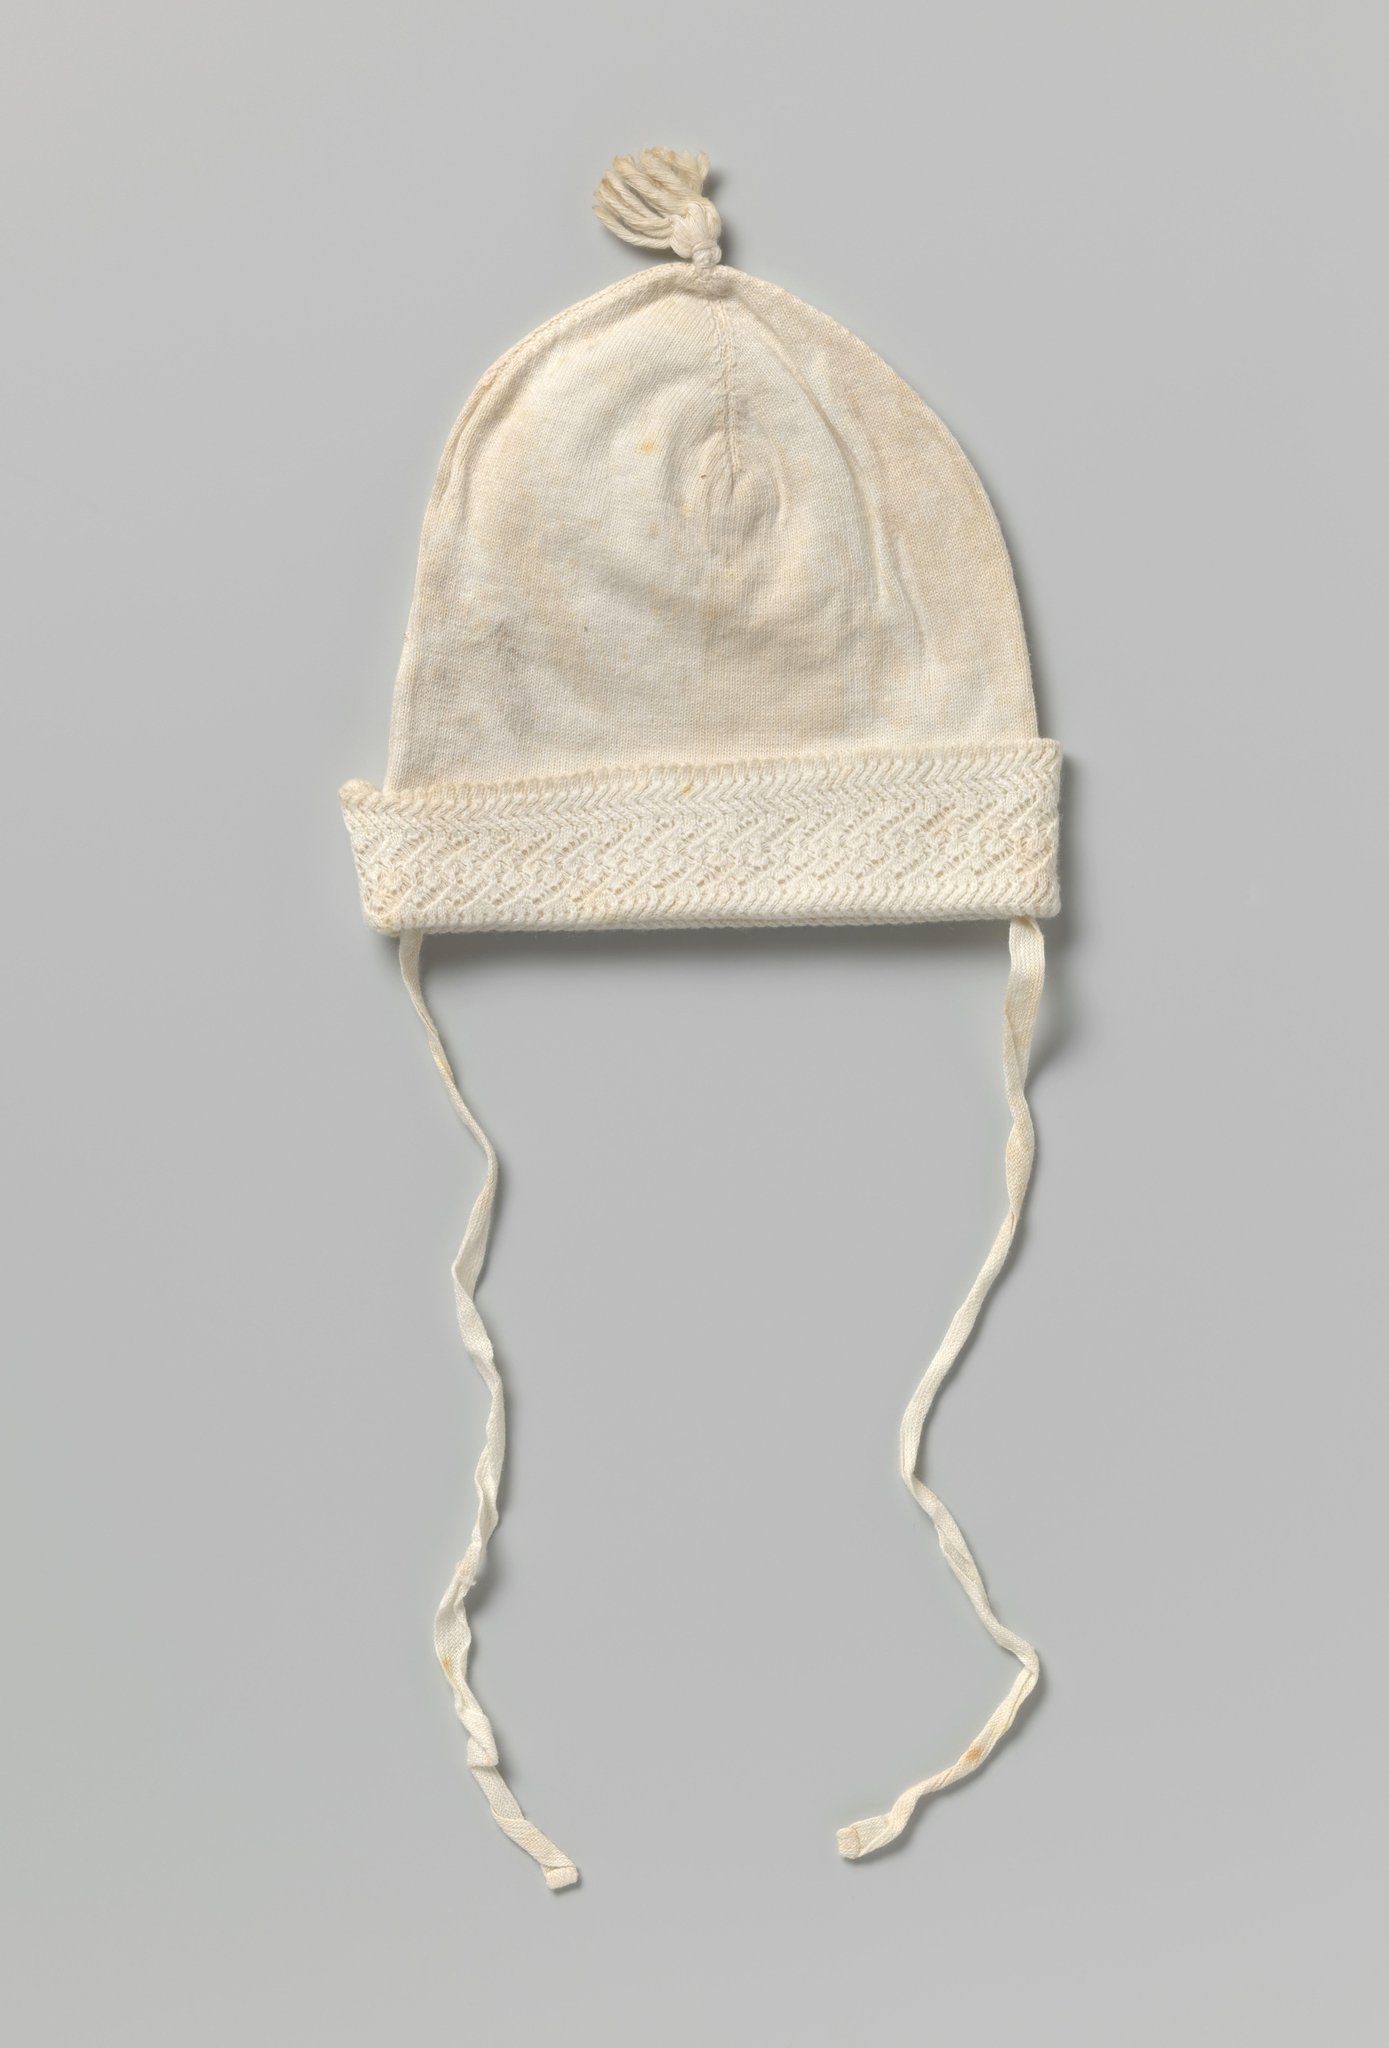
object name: cap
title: Gebreide muts van wit katoen met hele fijne tricotsteek, een kwastje bovenop en omgeslagen rand met ajourwerk; in rode kruissteek gemerkt: VG4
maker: Anonymous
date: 1840-1850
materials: cotton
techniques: embroidery, knitting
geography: netherlands